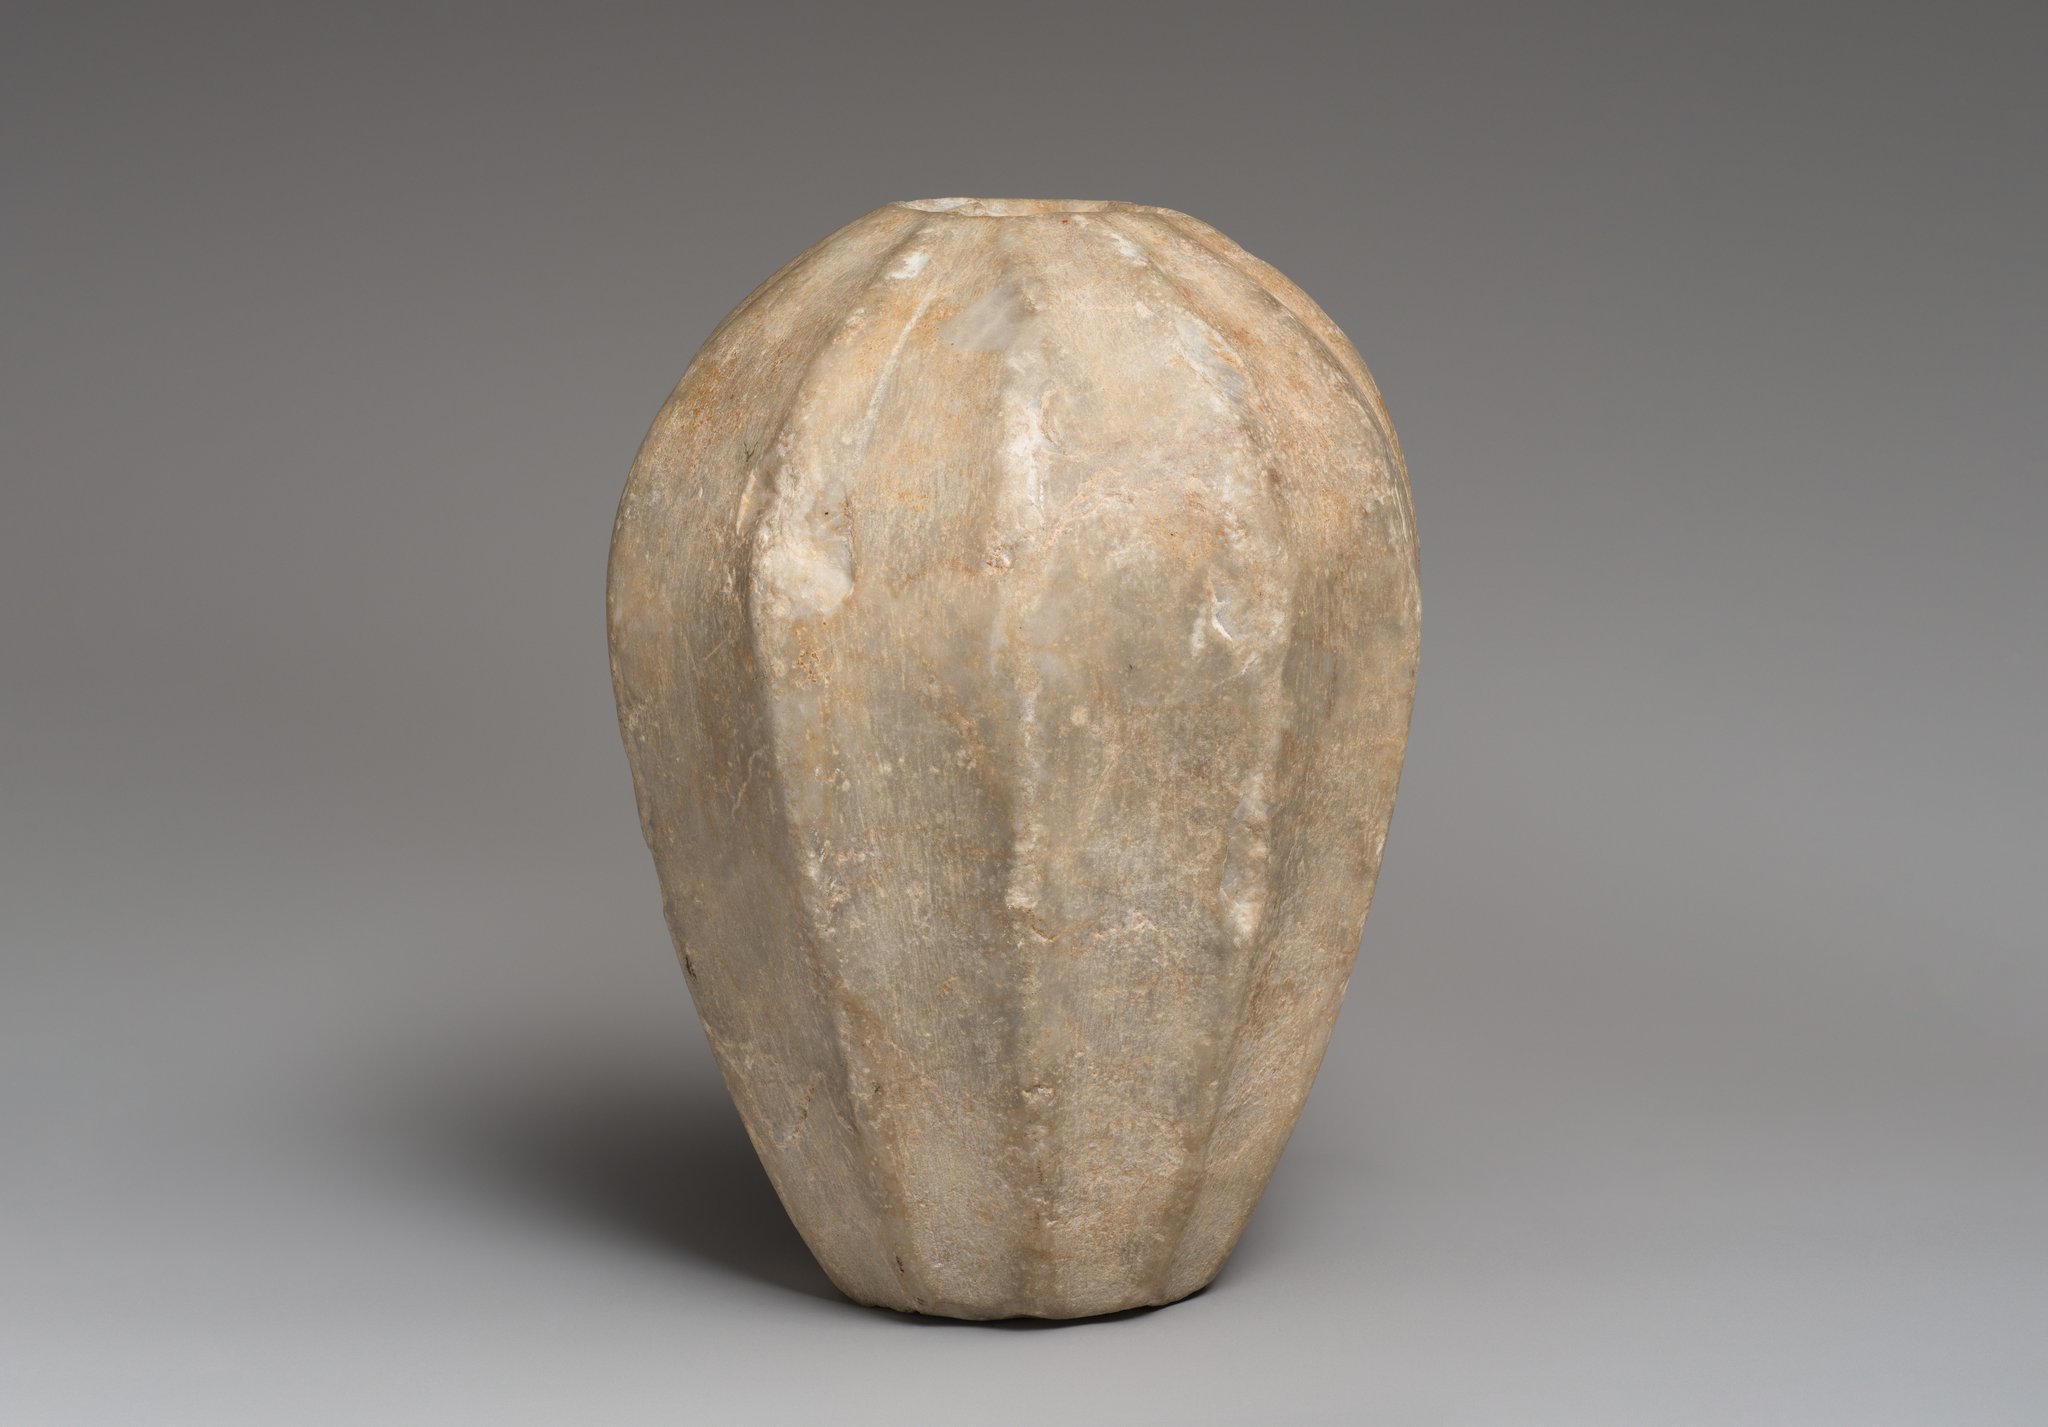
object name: mace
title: Mace head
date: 2700-2600 BCE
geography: mesopotamia